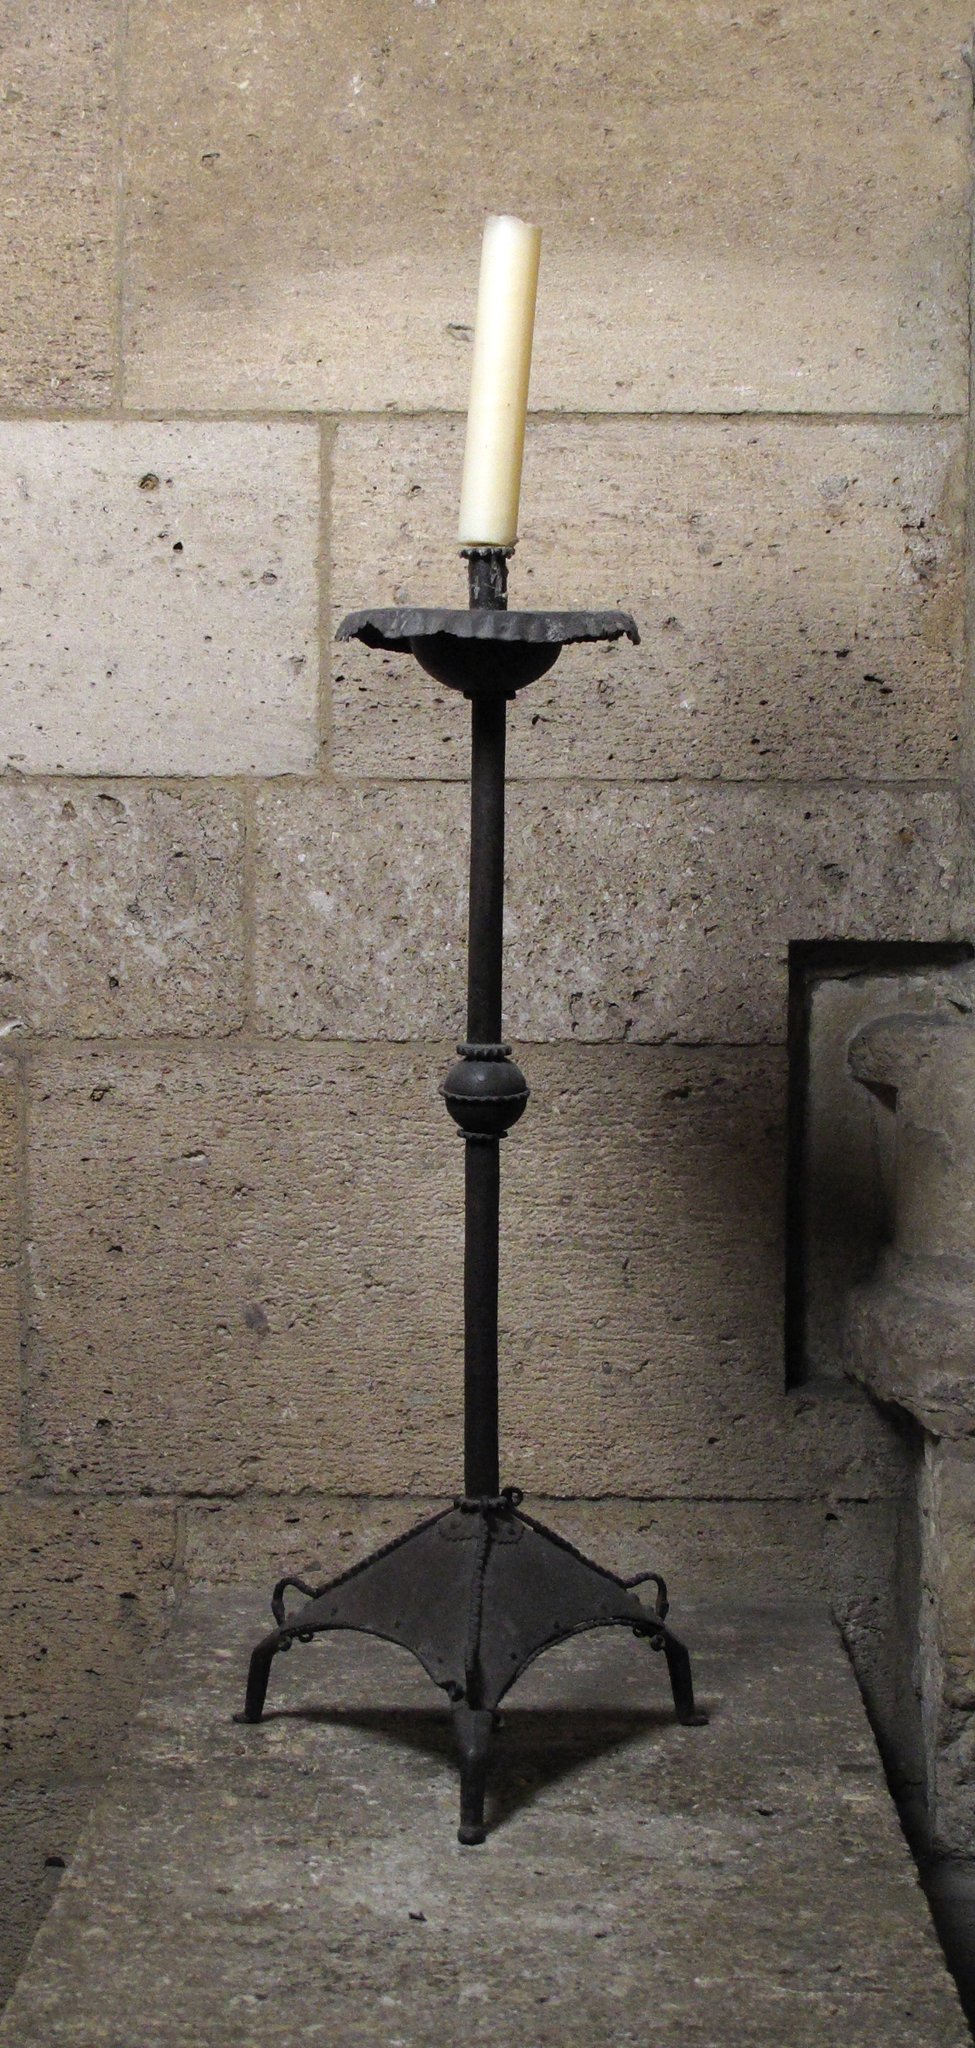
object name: candelabrum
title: Candelabra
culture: french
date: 1401-1500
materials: iron